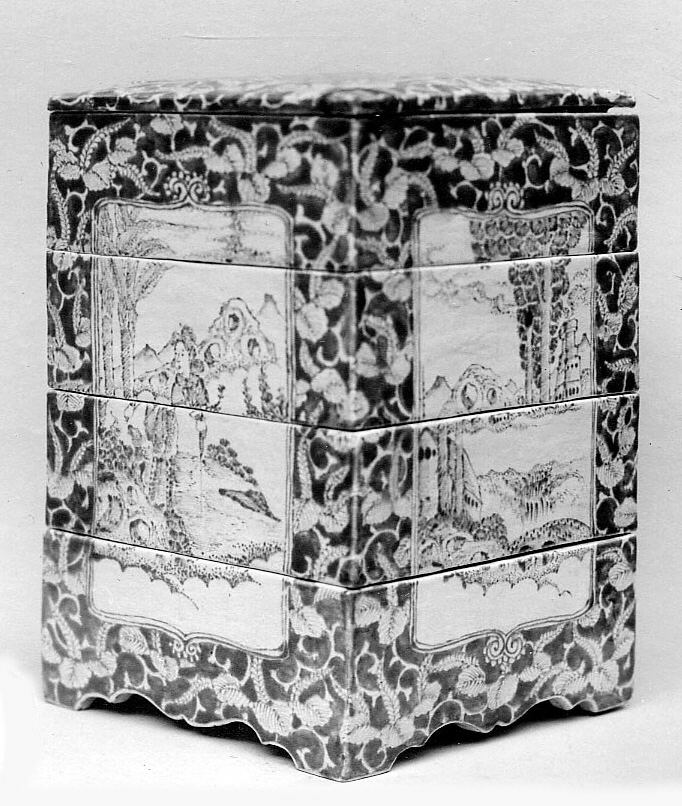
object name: tiered box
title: Tiered Box with Westerners and Landscapes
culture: japanese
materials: faience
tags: landscapes